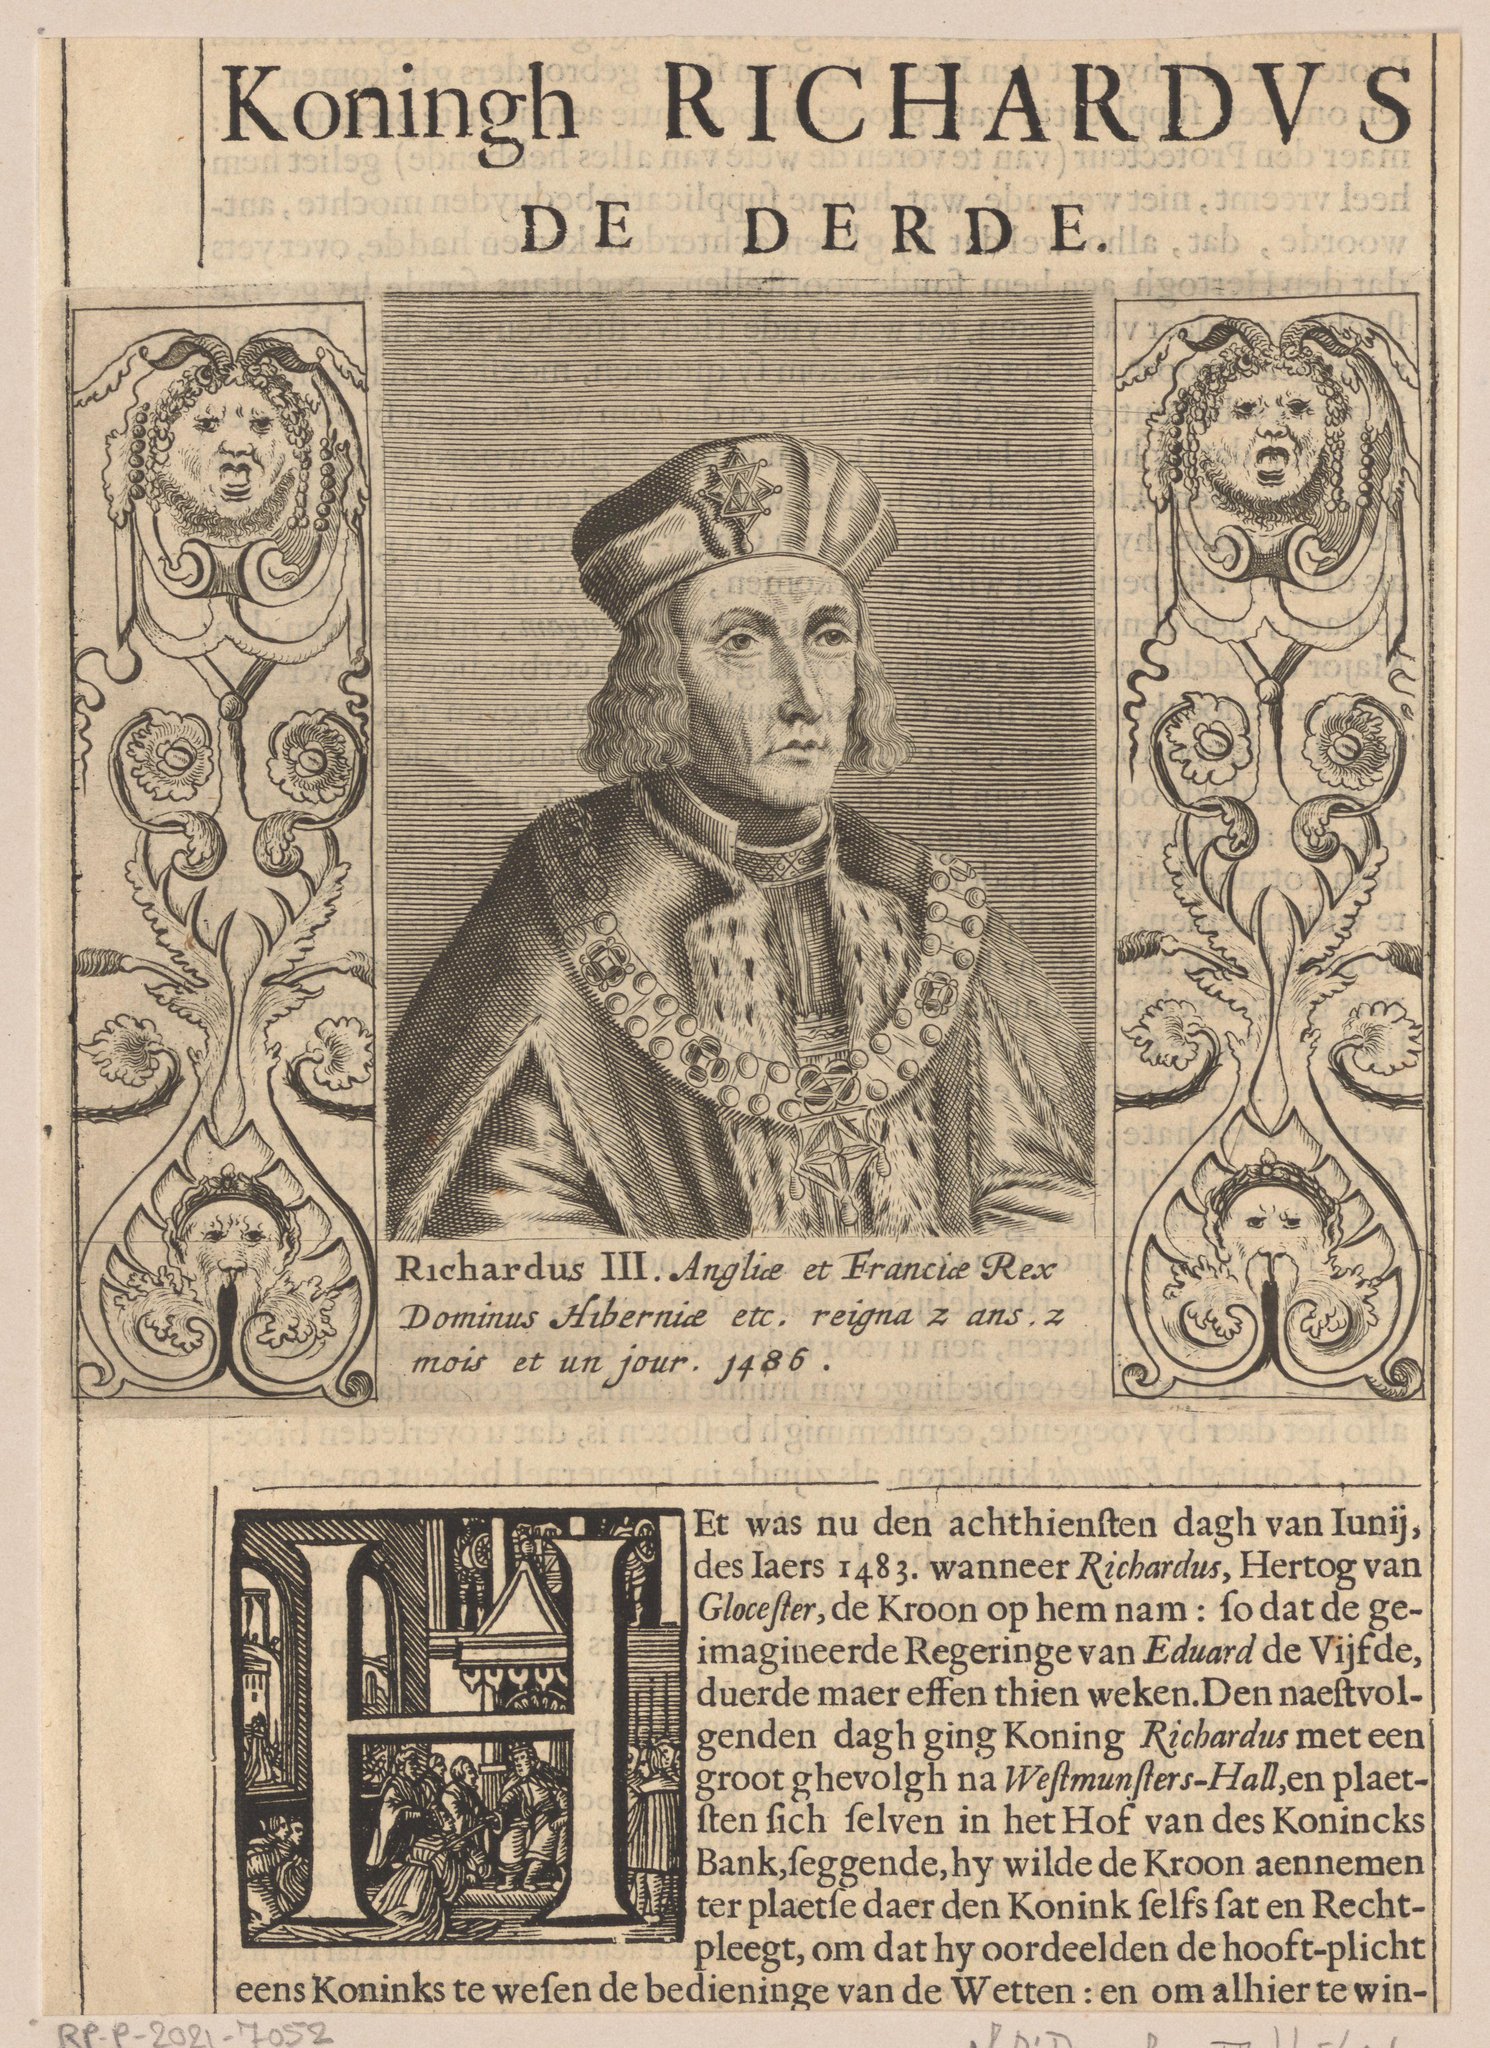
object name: book illustration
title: Portret van Richard III, koning van Engeland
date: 1649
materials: paper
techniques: engraving, letterpress printing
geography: amsterdam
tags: historical persons, king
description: Prent uit: Baker, Sir Richard. Cronyke van het leven en bedryff van alle de coningen van Engeland (...). Amsterdam: Cornelis Danckerts, 1649, dl. 2, p. 40.